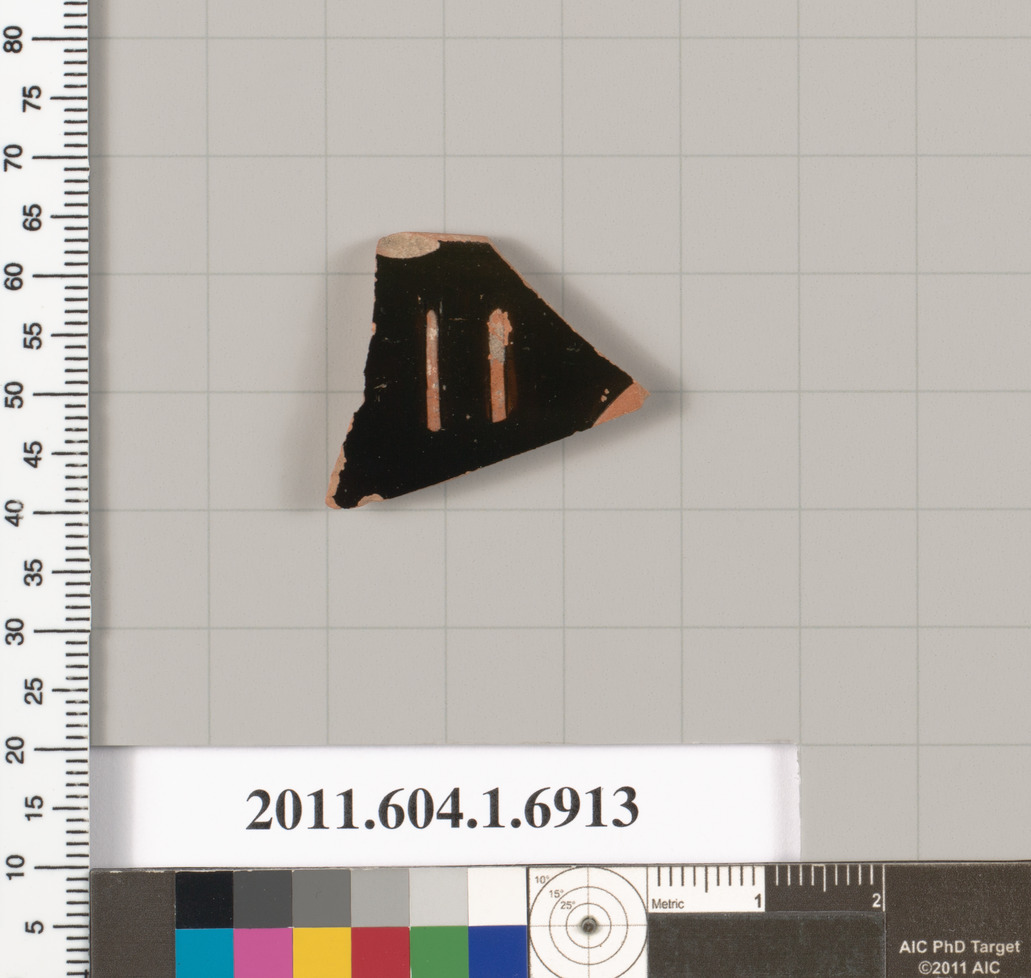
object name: kylix fragment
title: Terracotta fragment of a kylix (drinking cup)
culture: greek, attic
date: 490-470 BCE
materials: terracotta